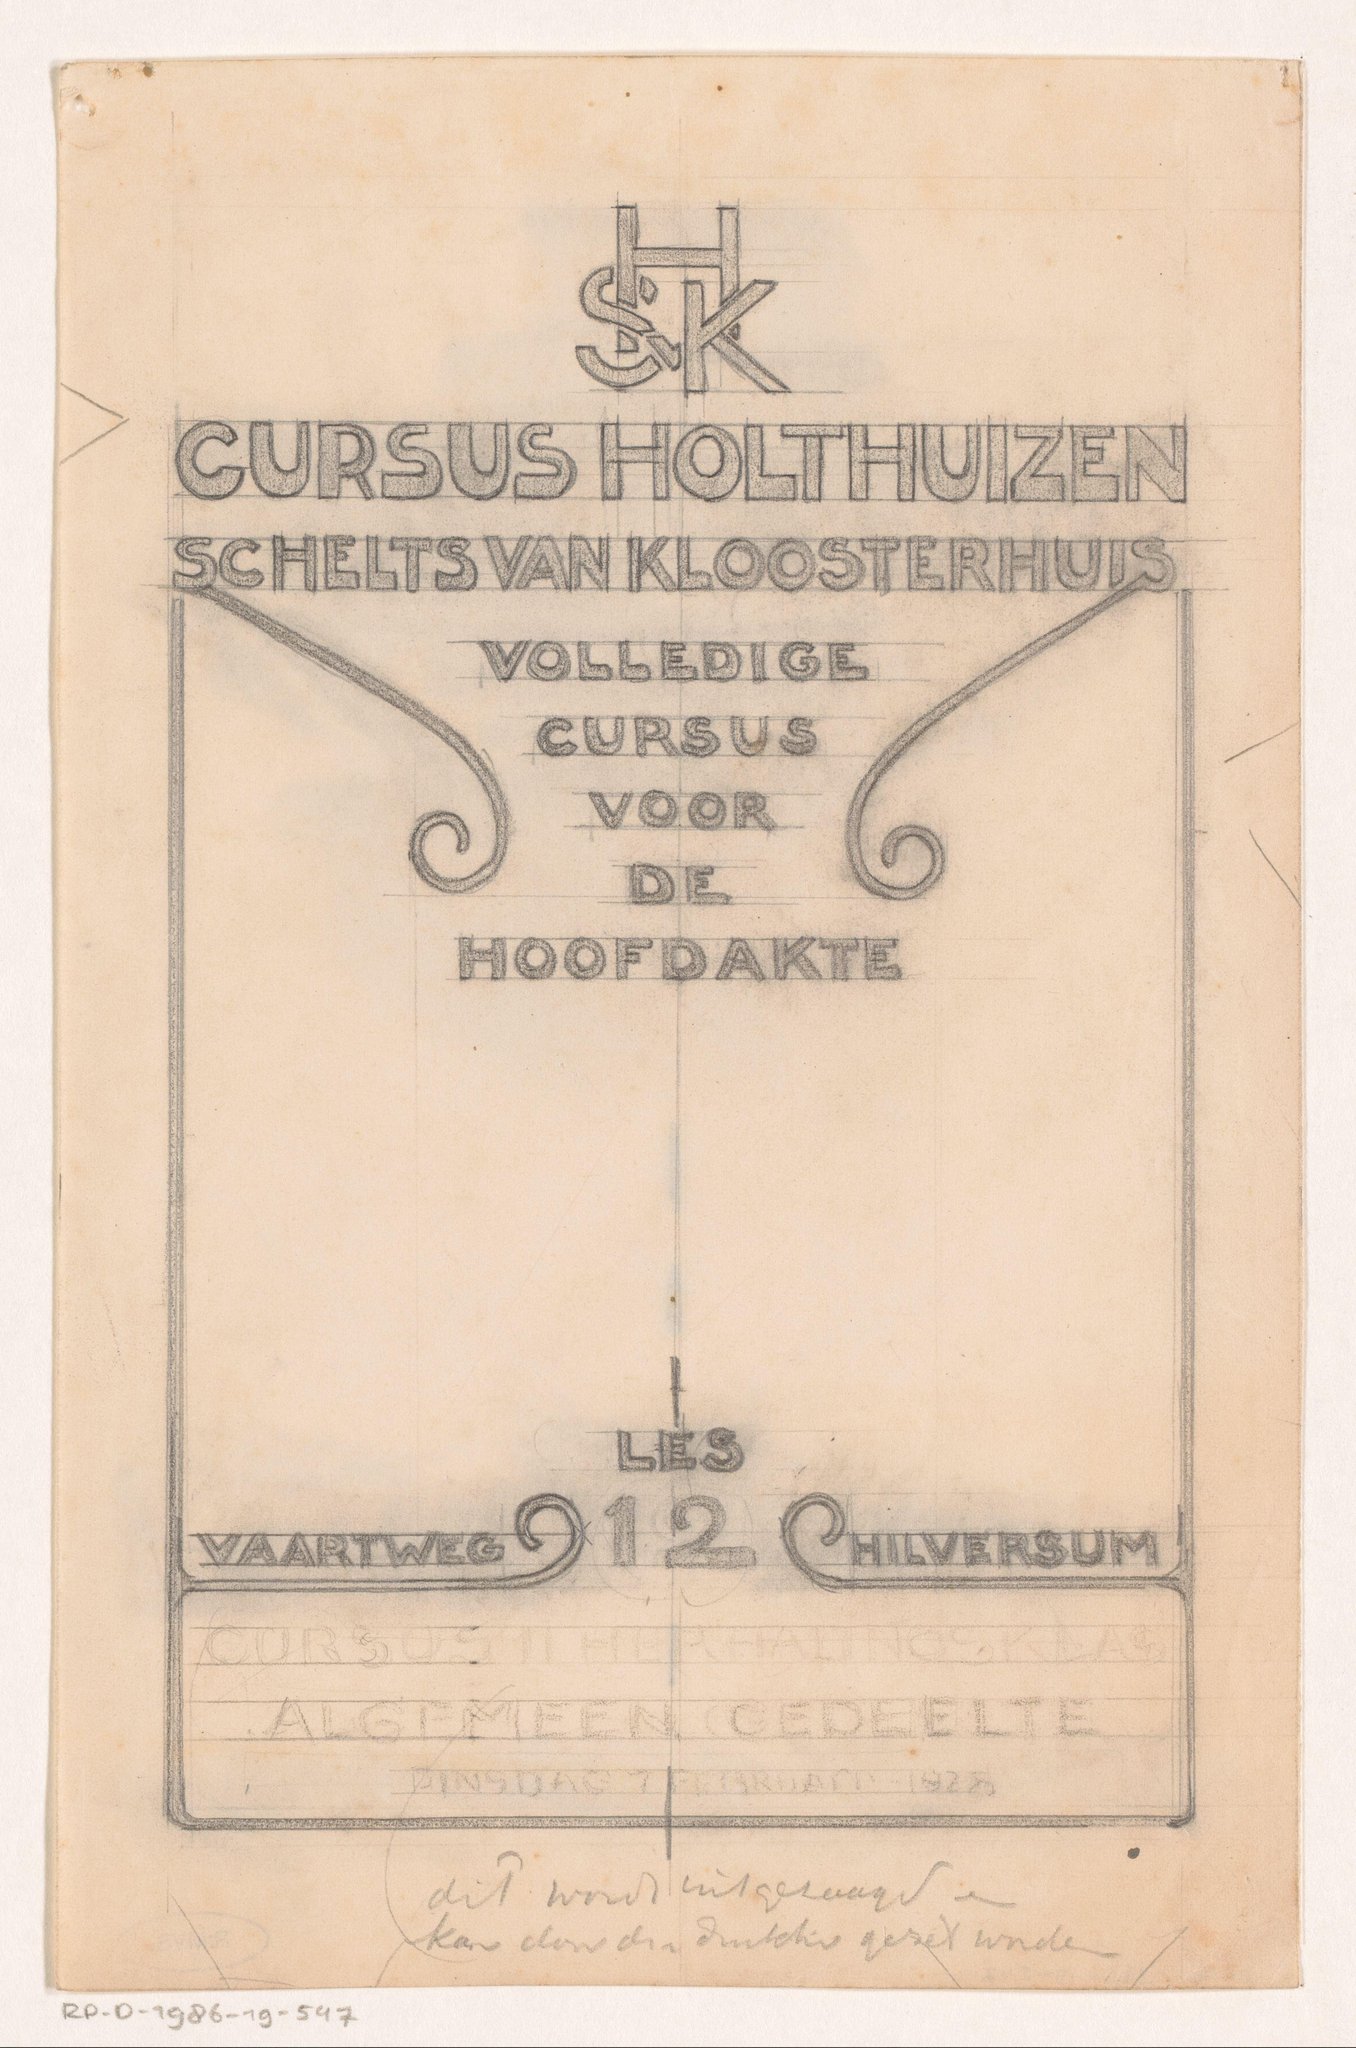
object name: design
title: Omslagontwerp voor: Cursus Holthuizen. Volledige cursus voor de hoofd-akte, zonder jaar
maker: reinier willem petrus de vries (1874-1953)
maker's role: draughtsman, print maker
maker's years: 1874-1953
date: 1884-1952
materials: pencil, paper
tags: magic mathematical figures; magic numbers, words, monograms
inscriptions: collector's mark: ‘R:MVS.’, annotation: ‘dit wordt uitgezaagd en/ kan door den drukker gezet worden’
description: Ontwerp met een monogram met de letters HSvK.